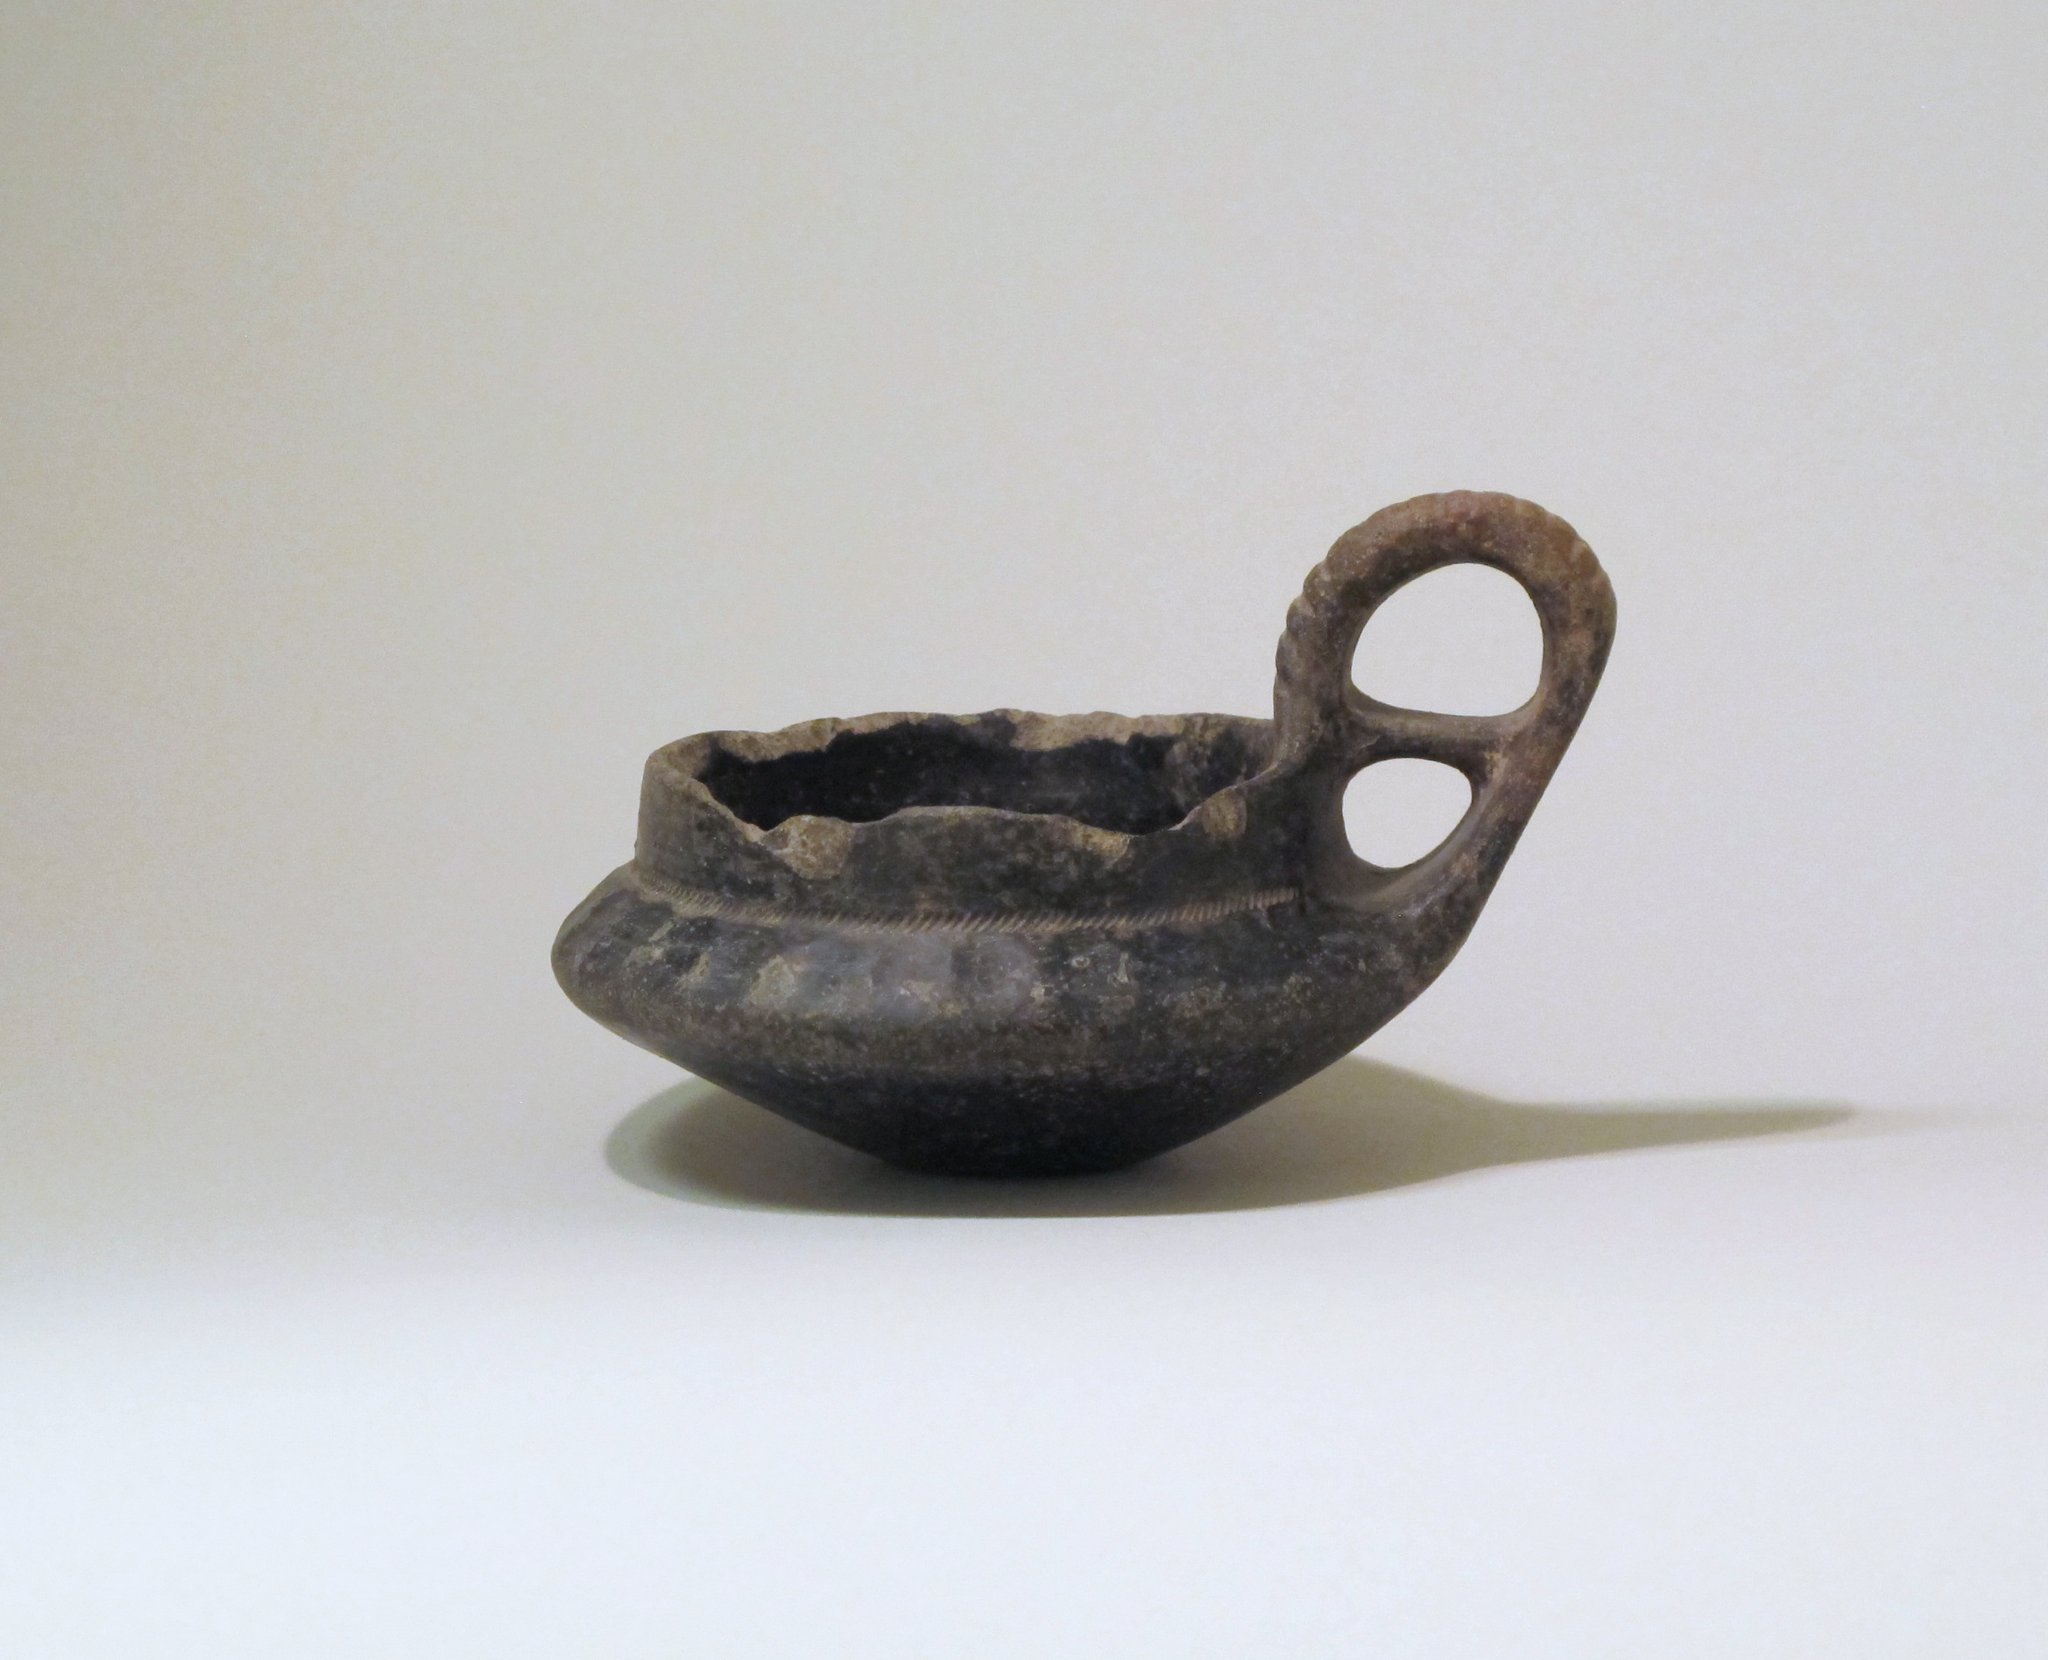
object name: cup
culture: etruscan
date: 800-701 BCE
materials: terracotta